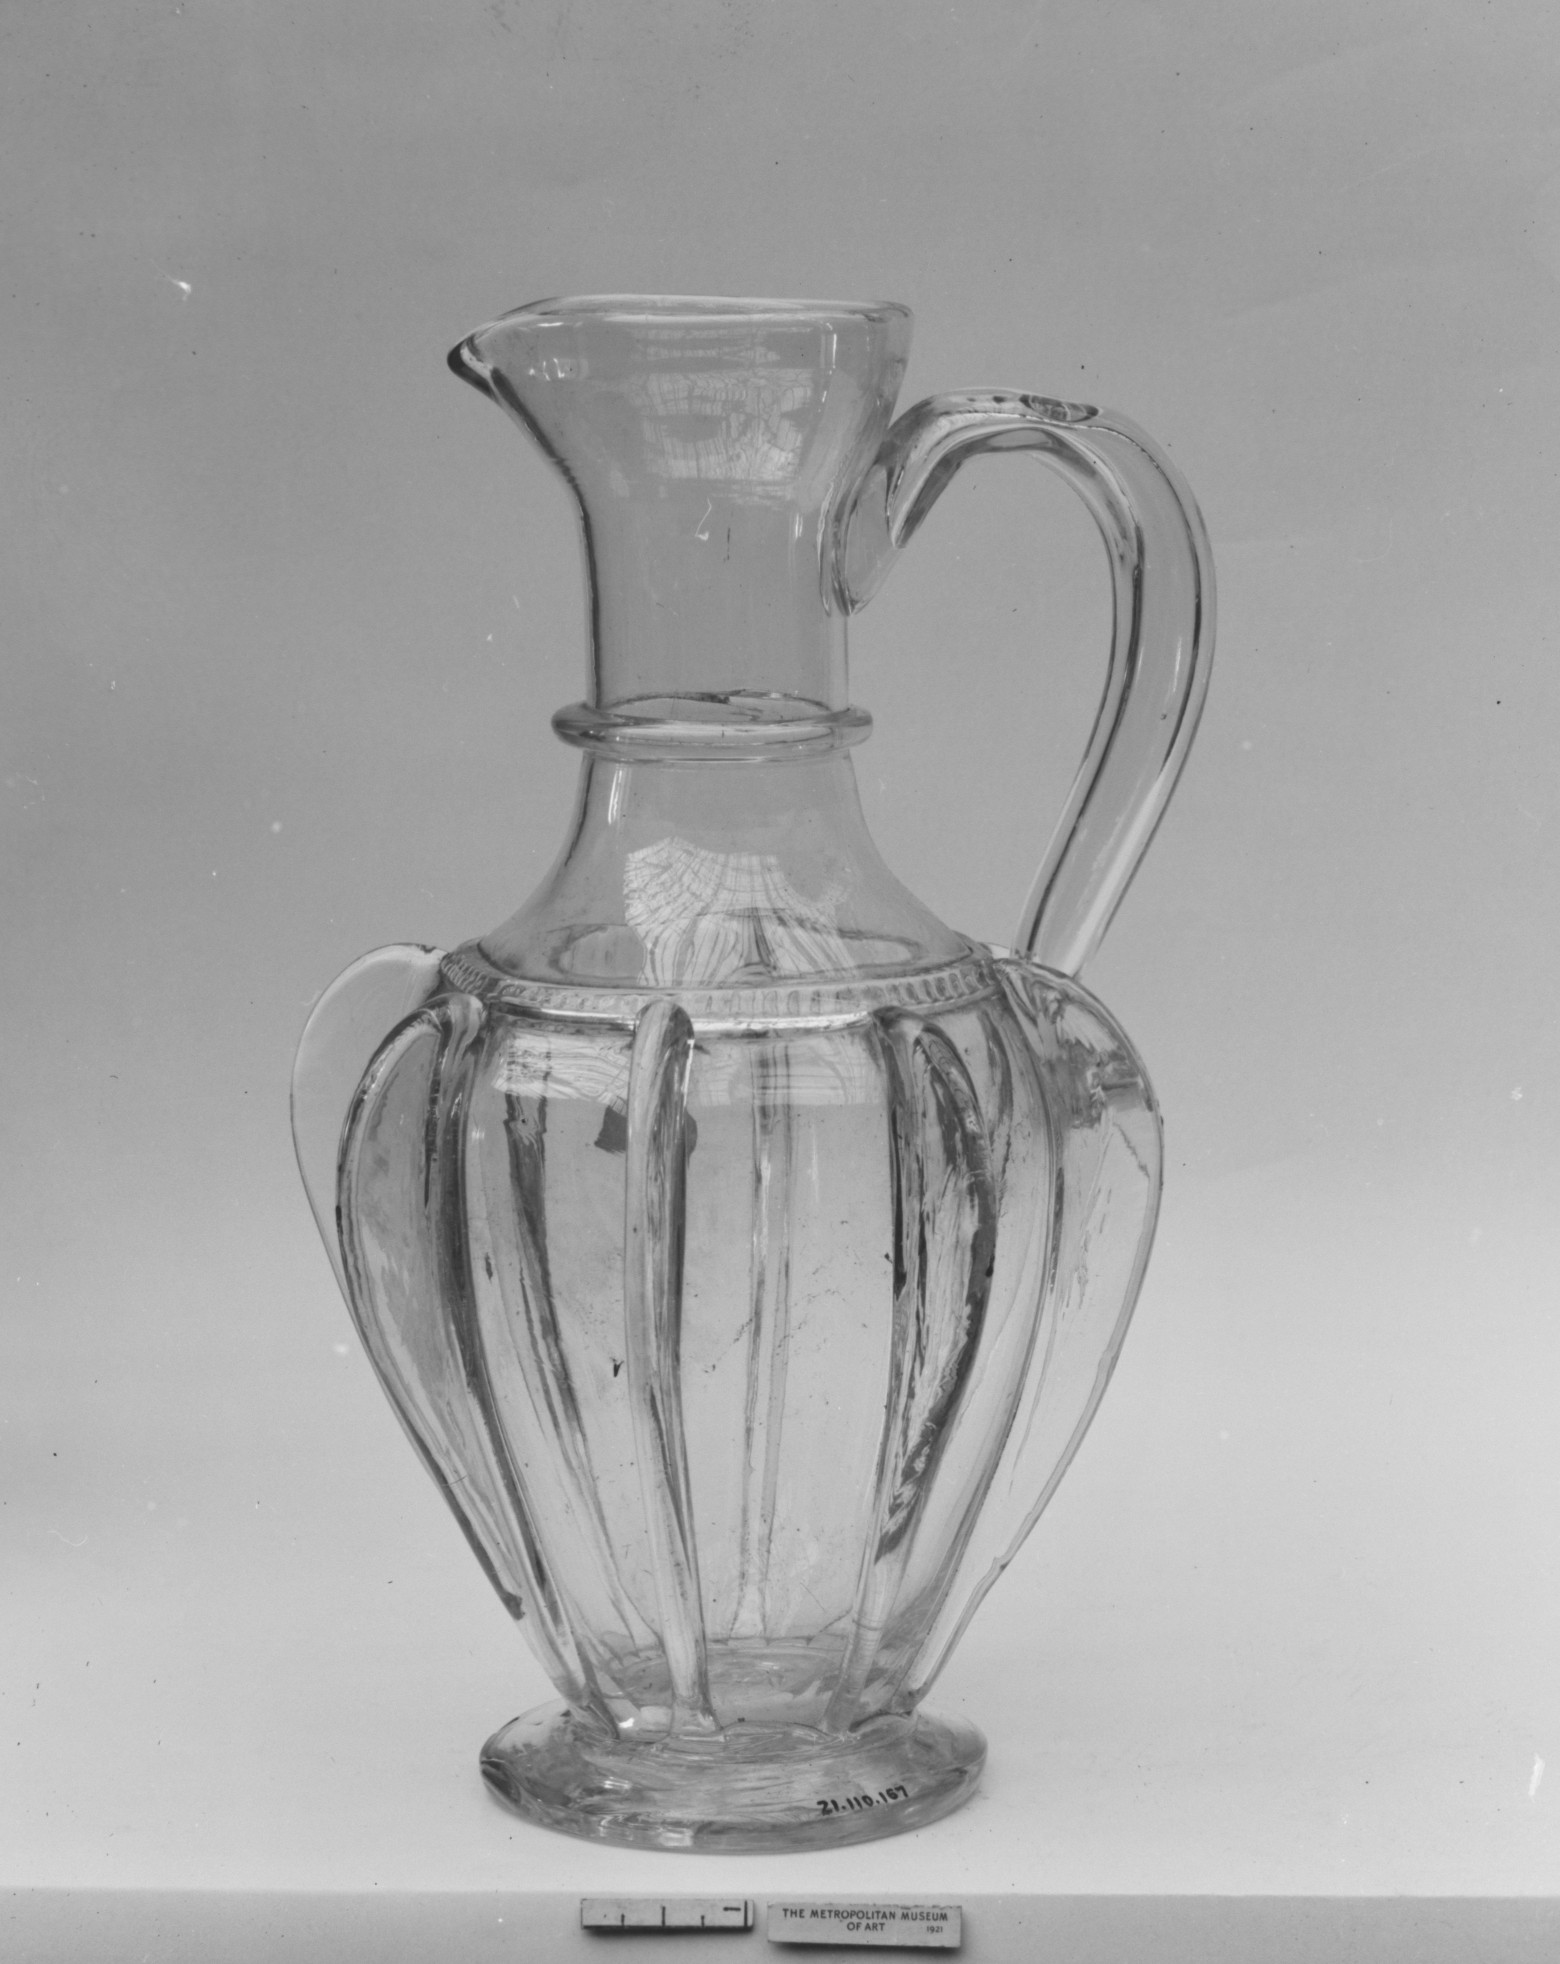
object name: ewer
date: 1701-1800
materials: glass